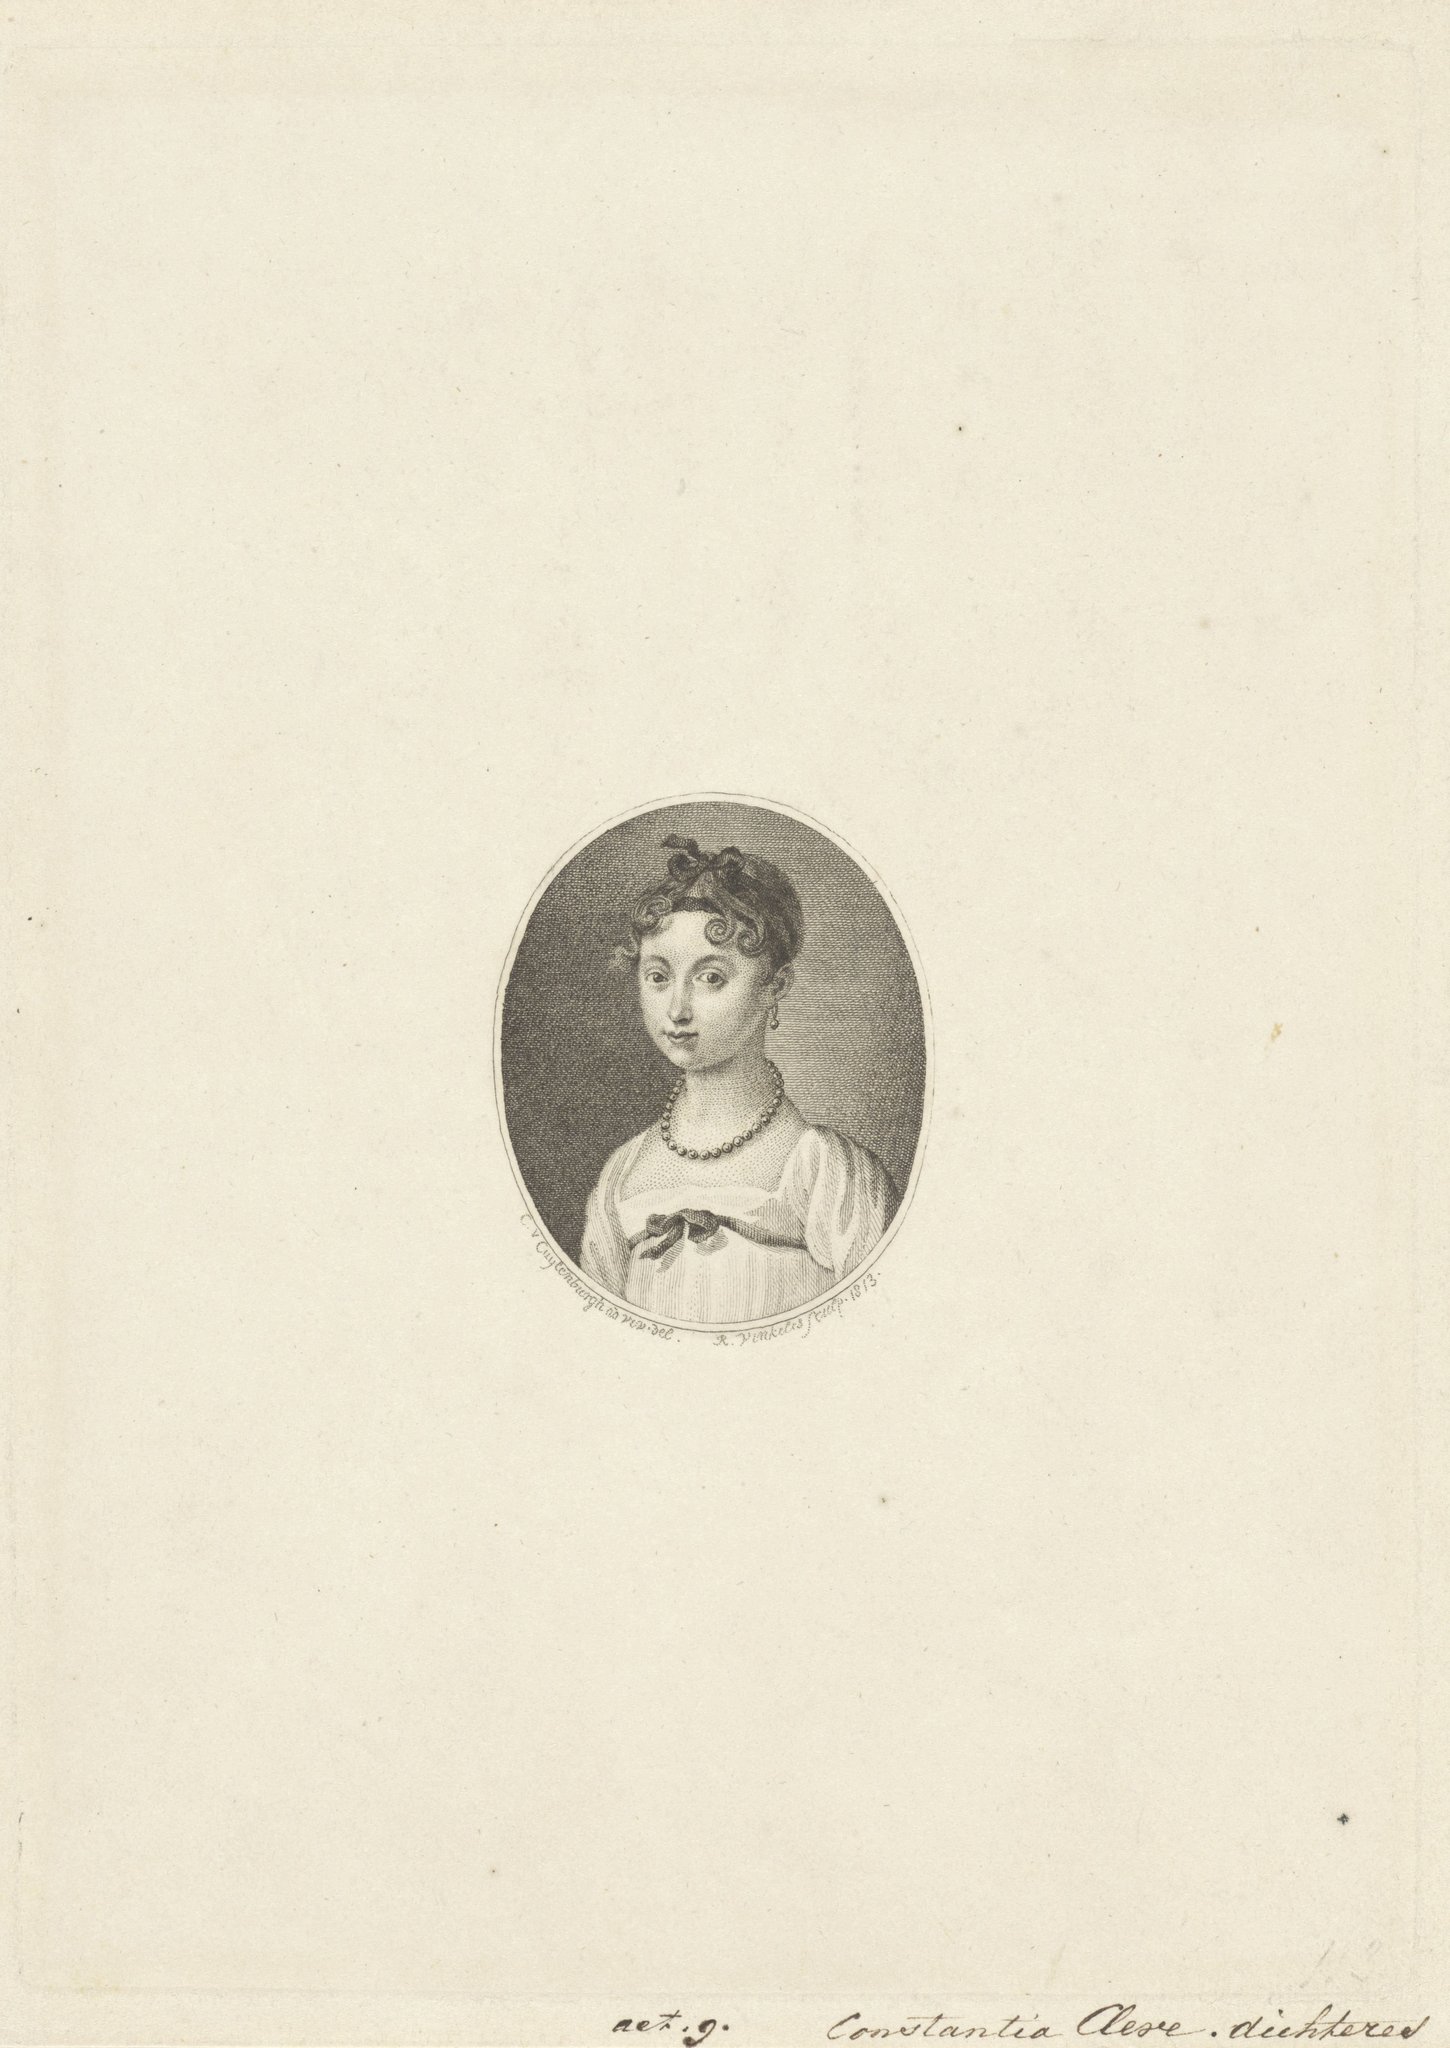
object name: print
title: Portret van Johanna Constantia Cleve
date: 1813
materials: paper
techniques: etching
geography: amsterdam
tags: leiden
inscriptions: collector's mark: Lugt 2228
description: Portret van de jeugdige Nederlandse dichteres Johanna Constantia Cleve.